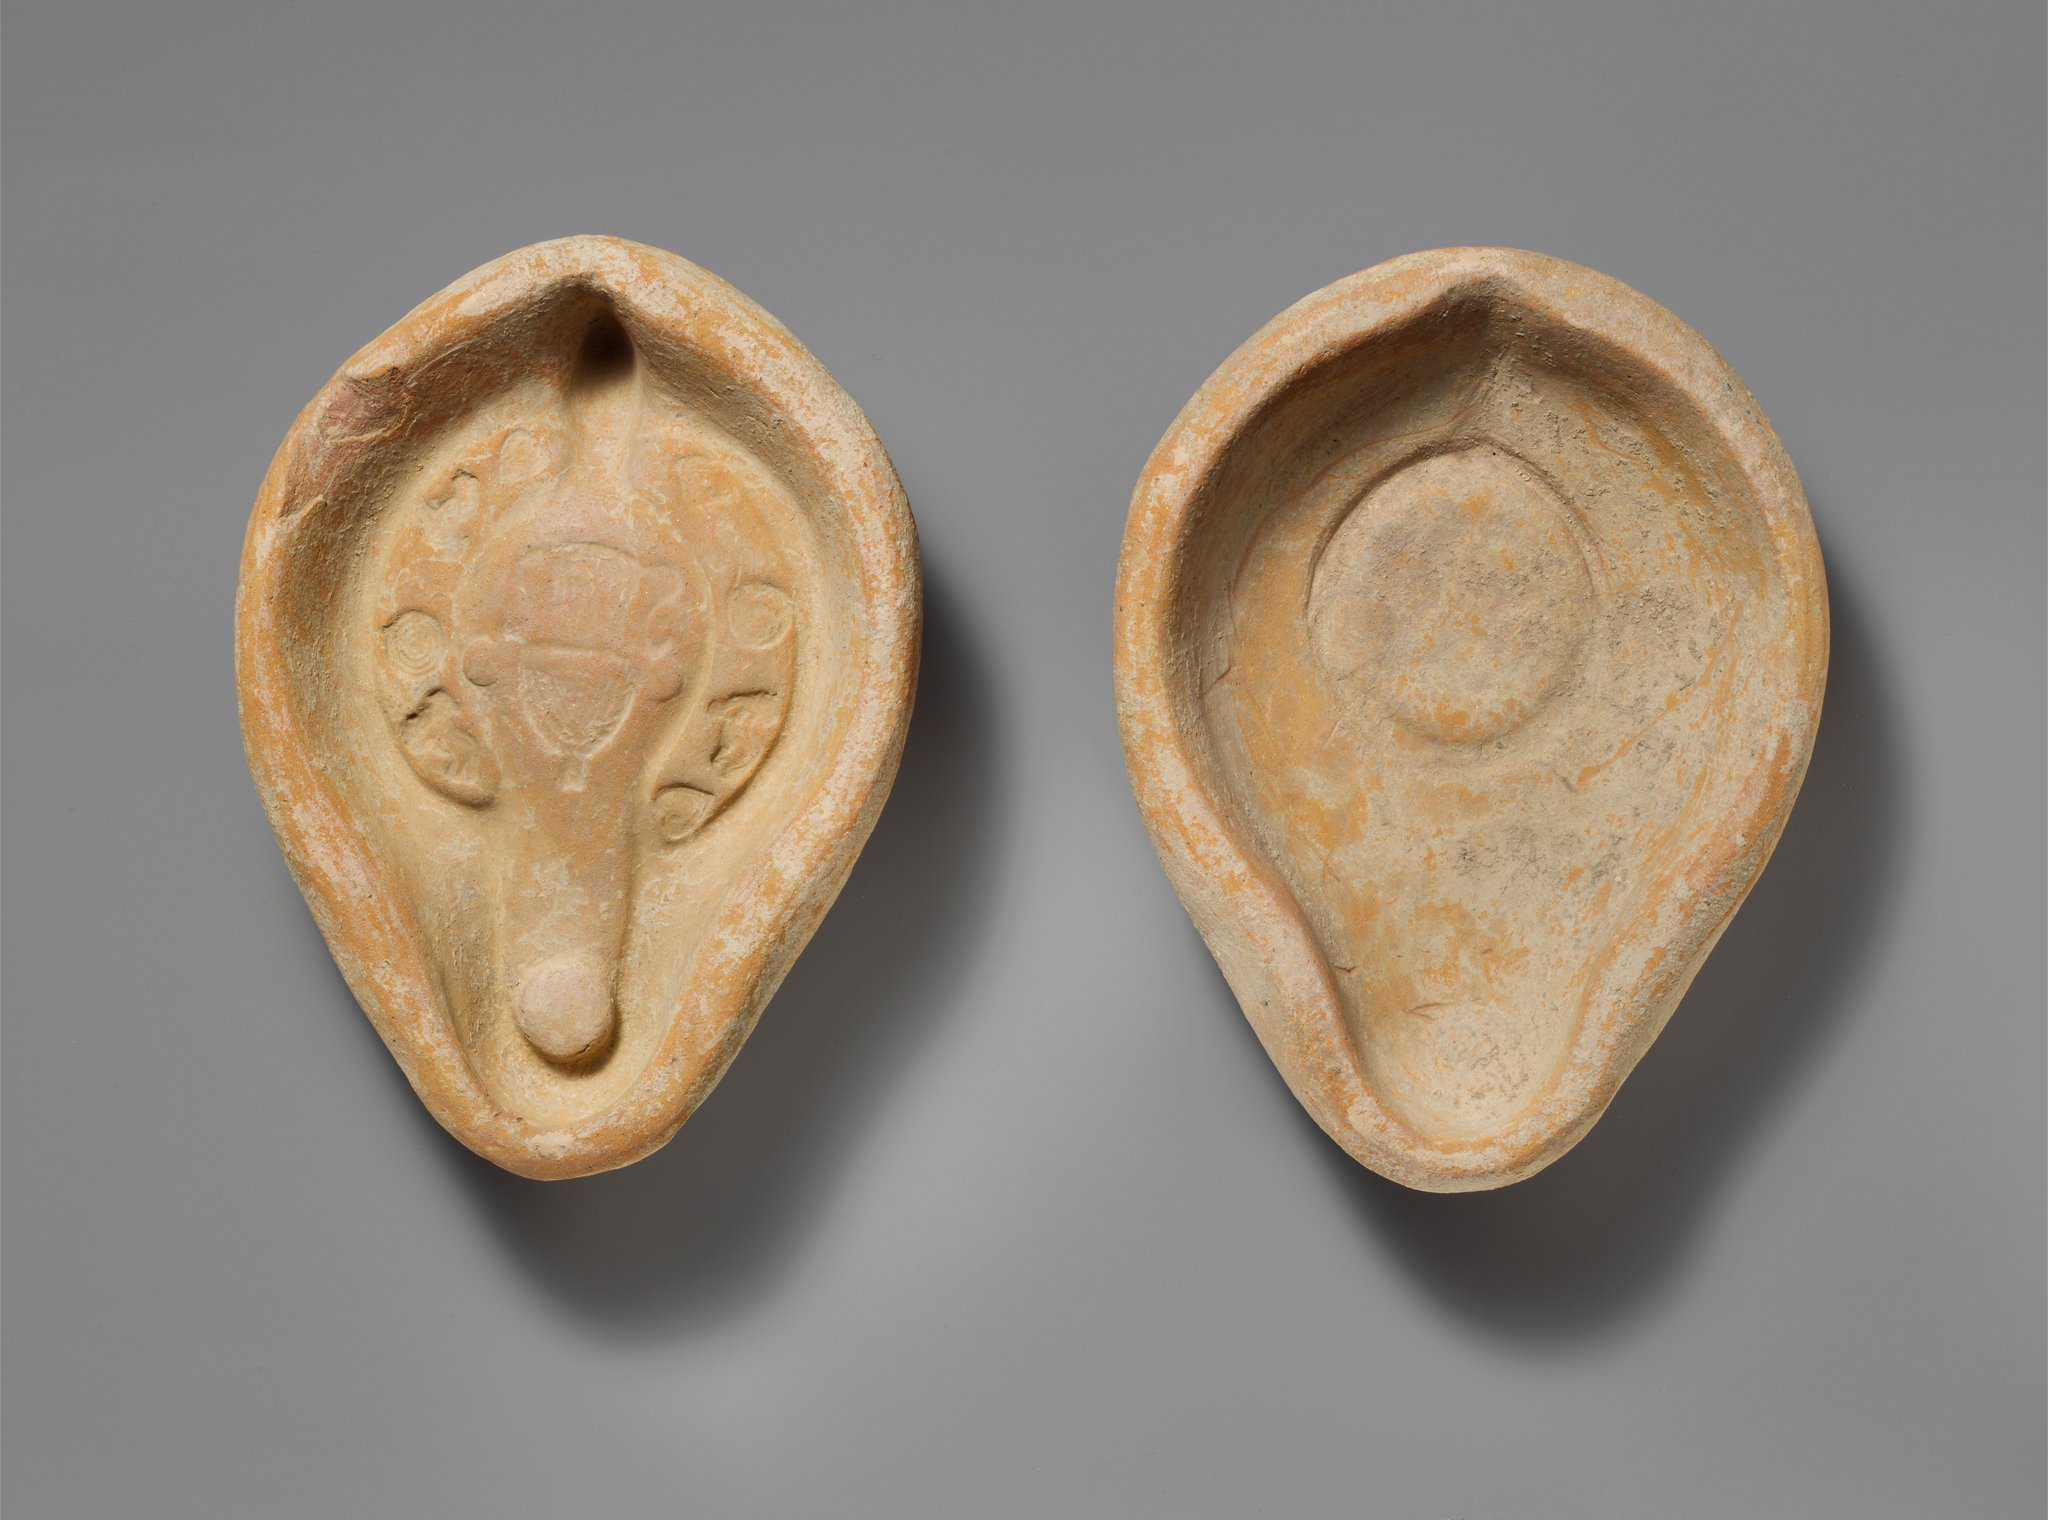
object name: lamp mold, top and bottom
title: Terracotta molds for a lamp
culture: roman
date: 401-500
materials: terracotta